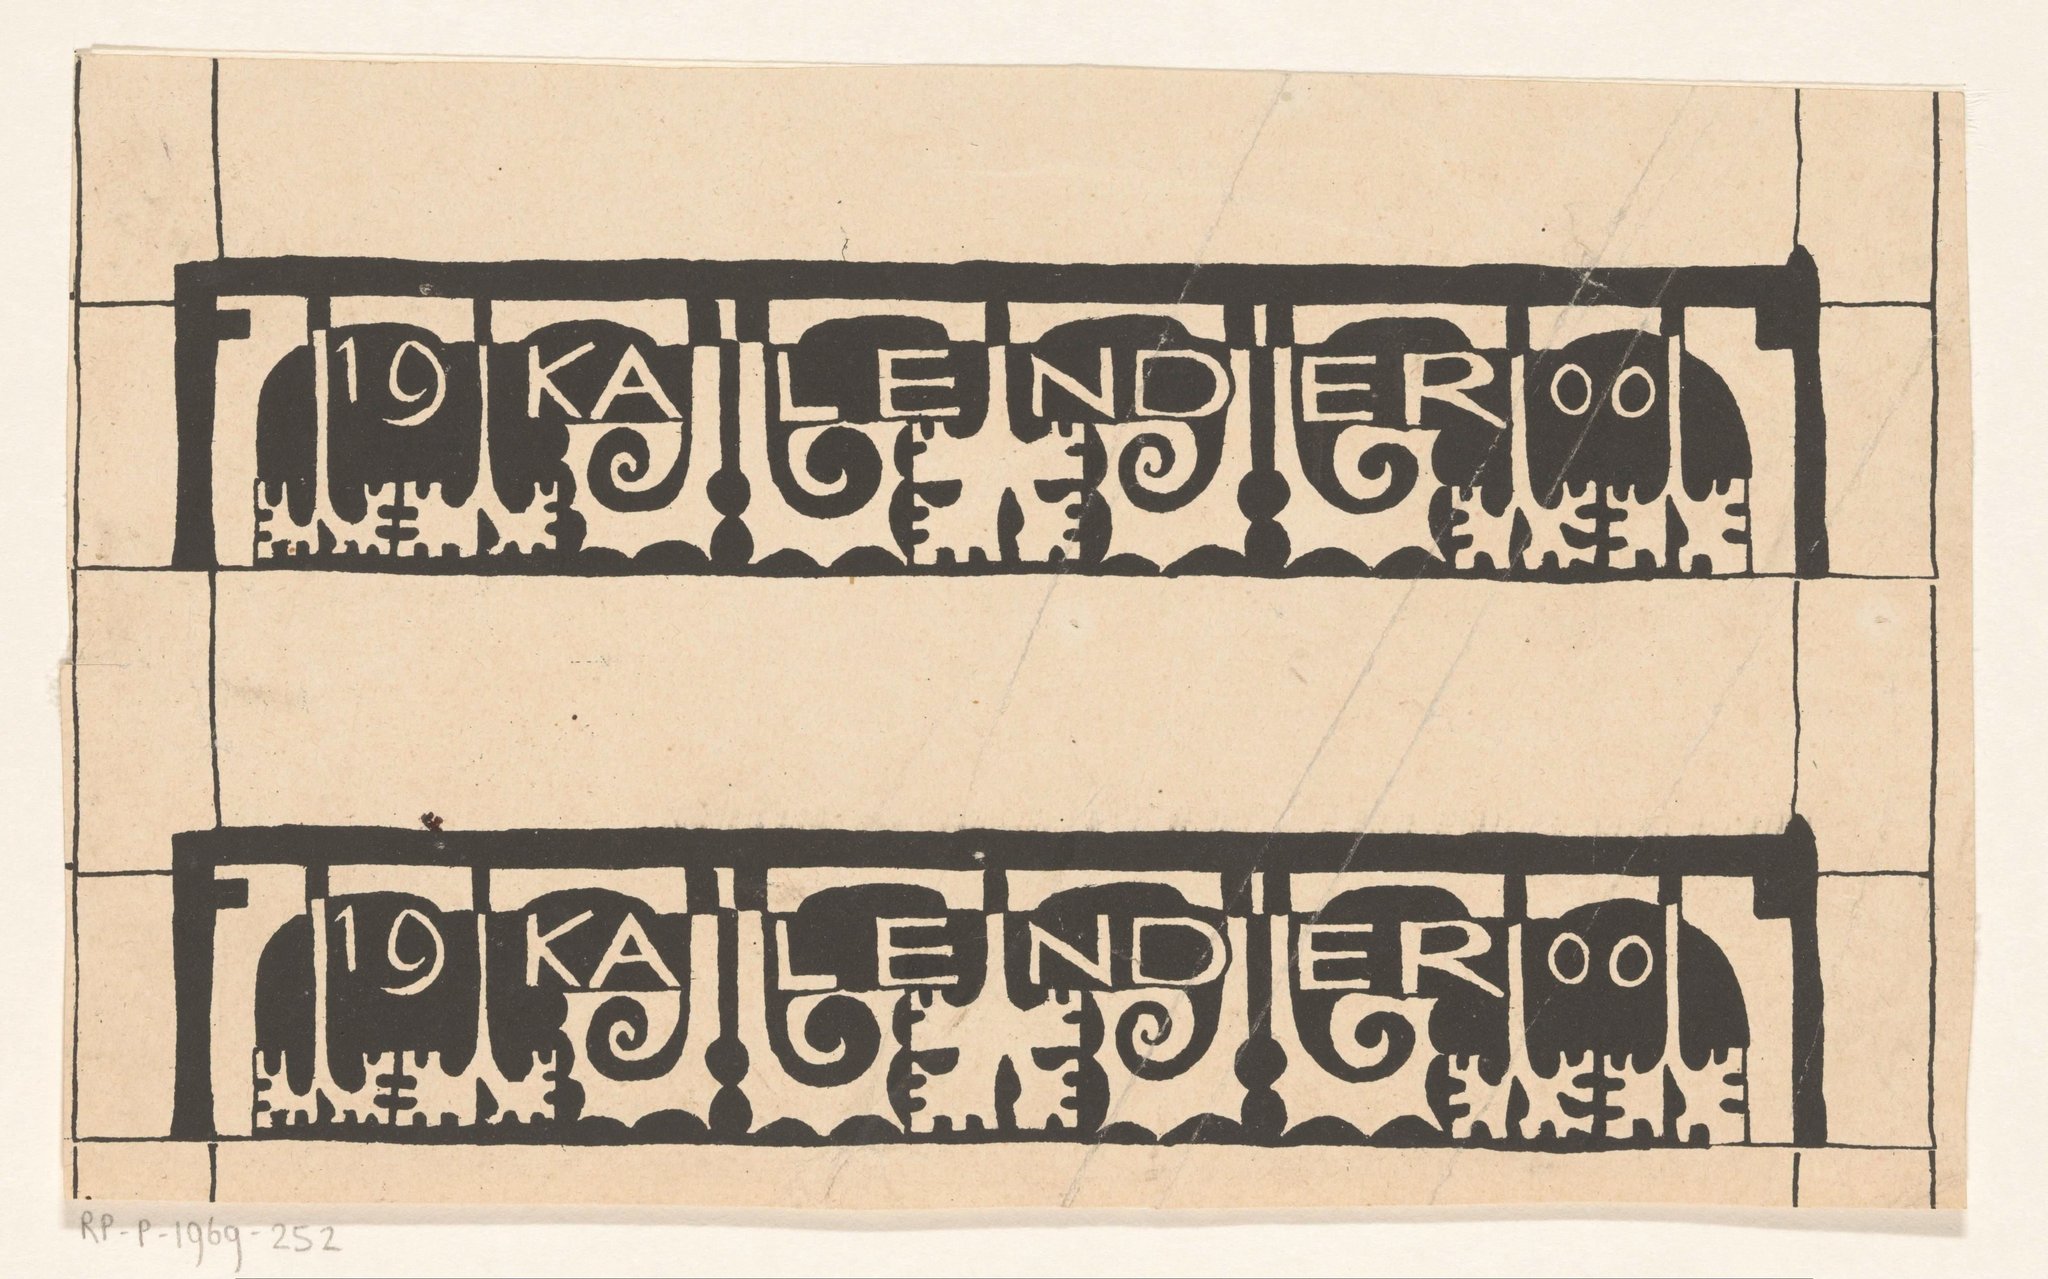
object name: print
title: Twee ontwerpen voor rand van kalender 1900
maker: carel adolph lion cachet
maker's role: draughtsman, print maker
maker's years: 1864-1945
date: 1900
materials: paper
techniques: woodcut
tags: calendar, almanac, ornament derived from plant forms - aa - stylized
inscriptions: collector's mark: Lugt 2228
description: Tweemaal de tekst '19 Kalender 00' met eromheen gestileerde plantmotieven.